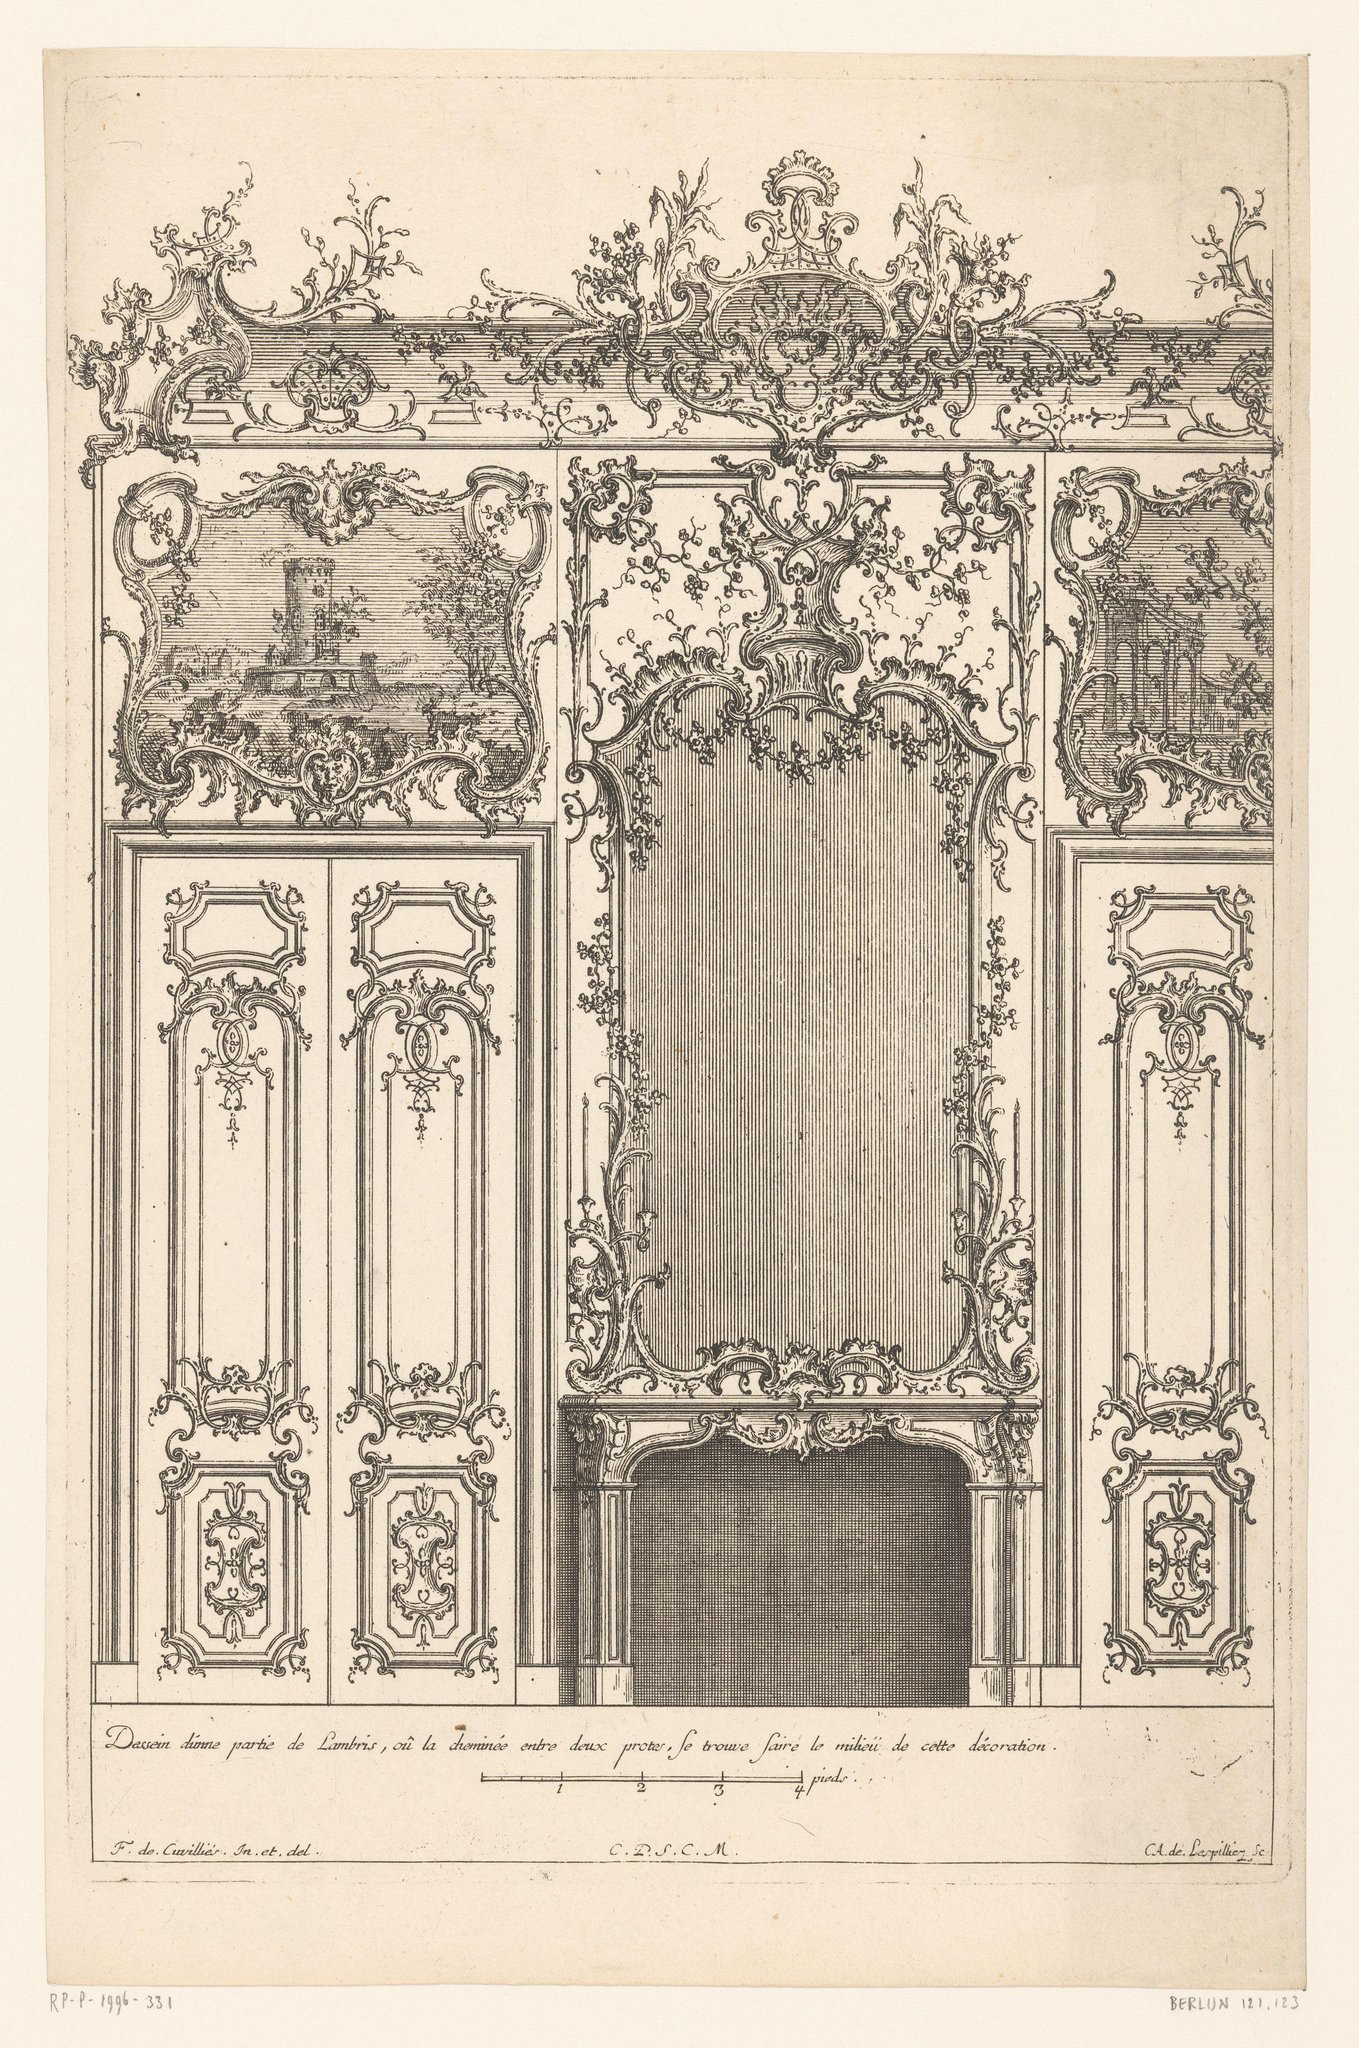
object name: ornament print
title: Schouw en deuren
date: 1735-1745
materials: paper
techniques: etching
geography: germany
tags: open hearth, fire-place, door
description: Een geornamenteerde schouw met rocailles en twee tweearmige kandelaars. Aan weerszijden twee geornamenteerde deuren met dessus-de-porte met ruïnelandschappen.